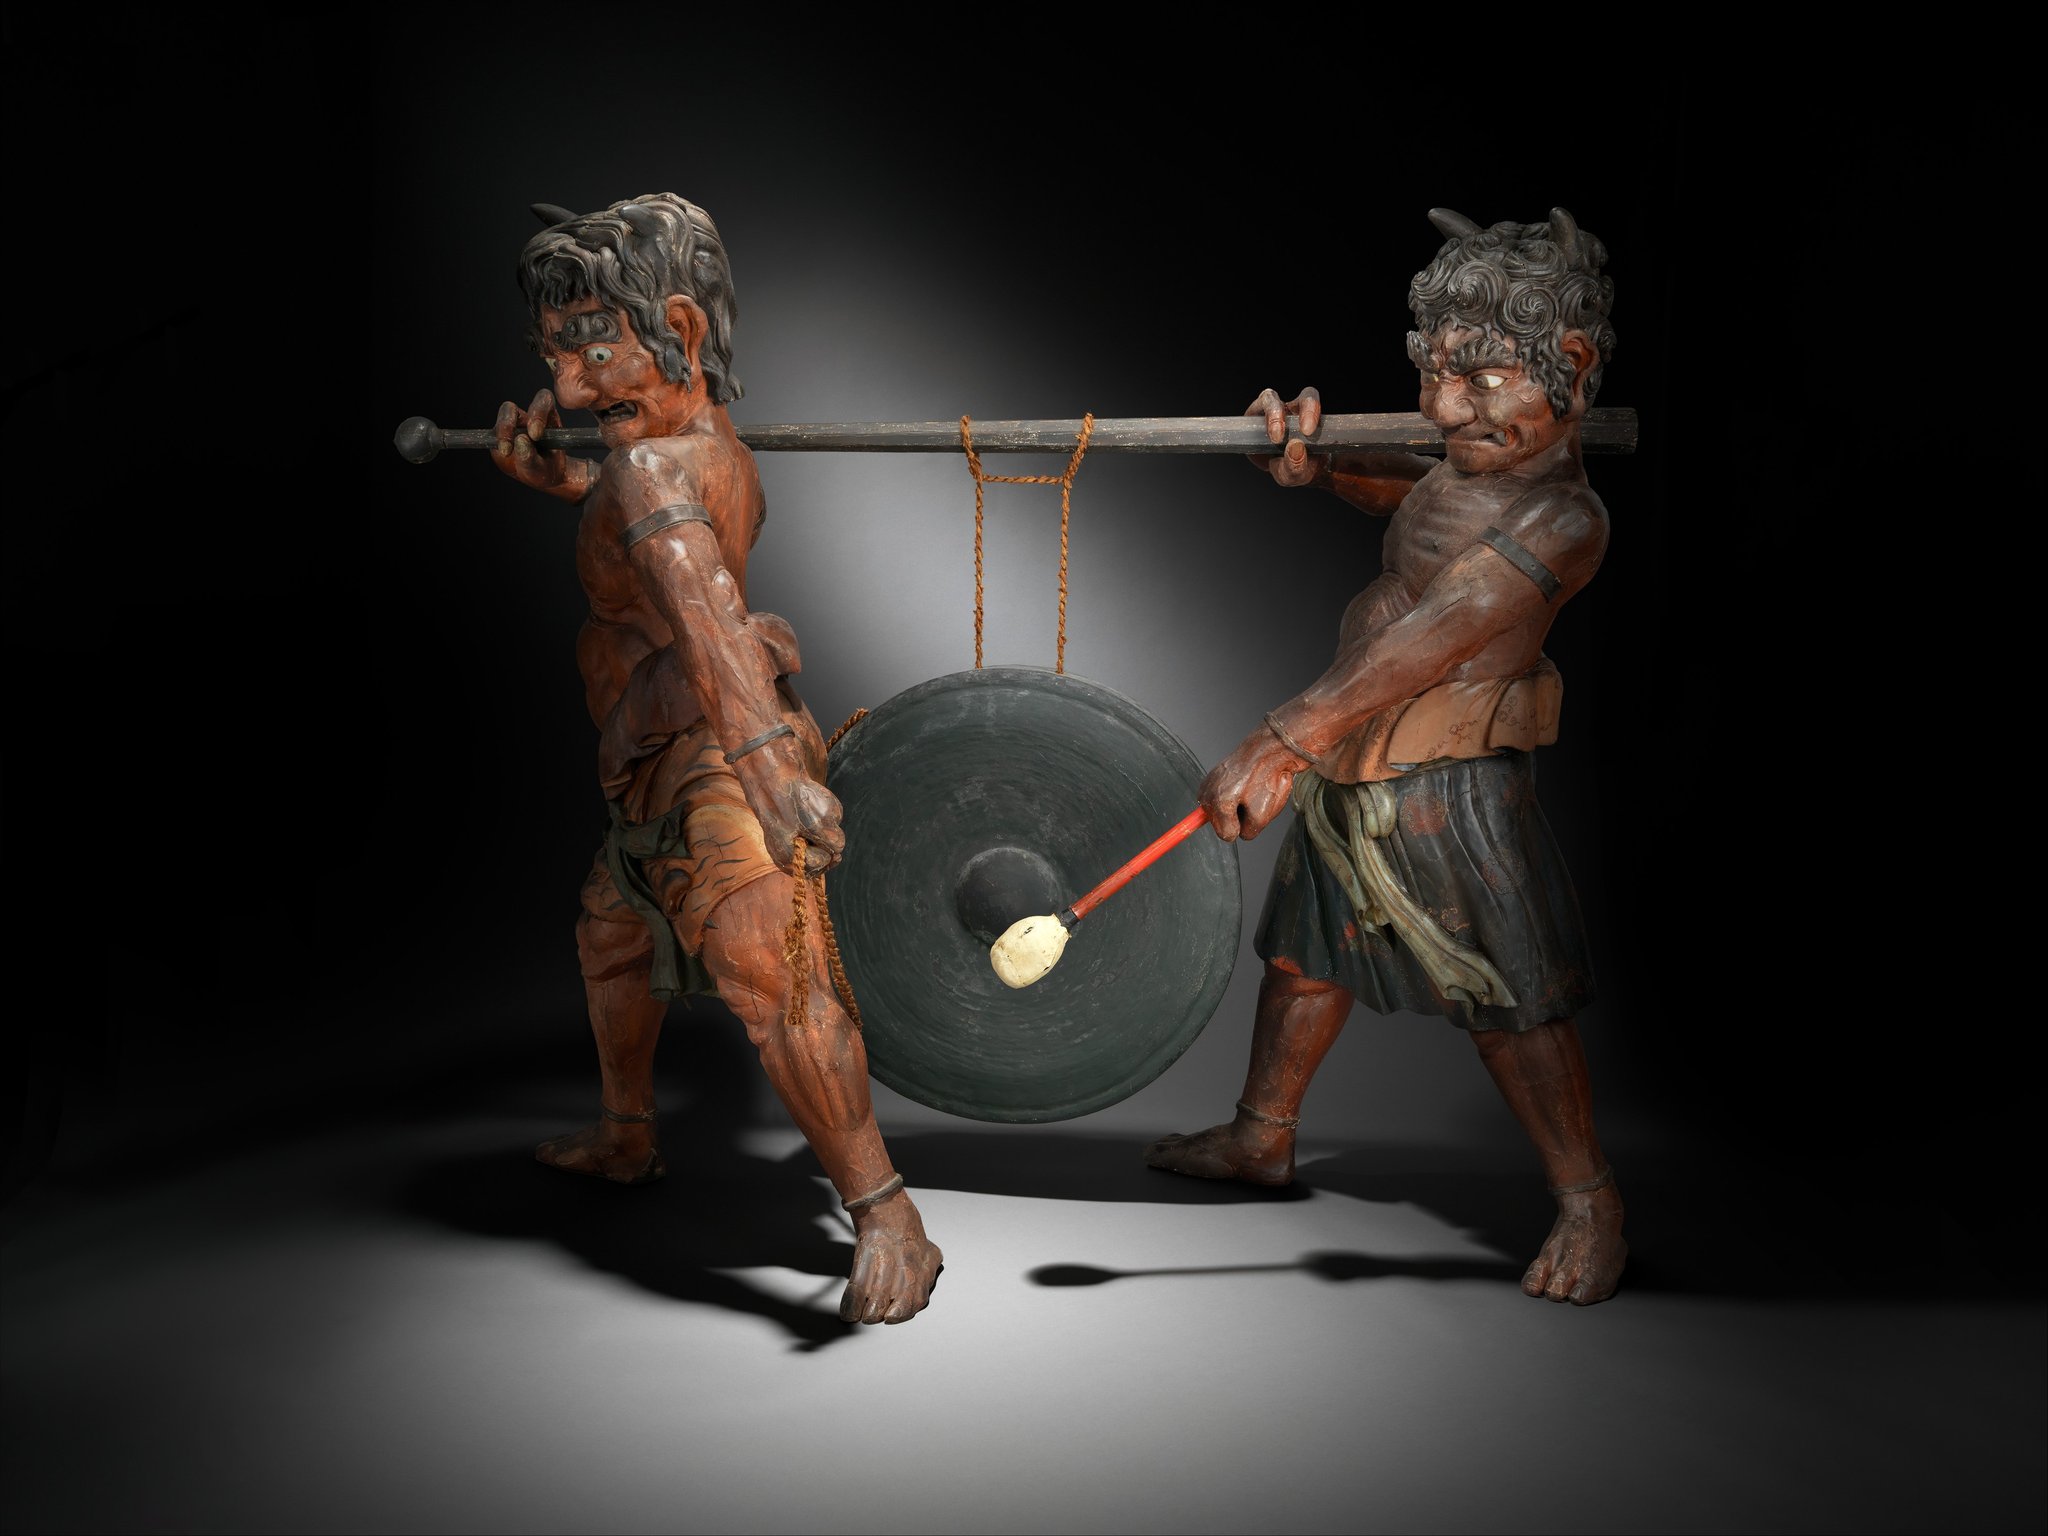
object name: gong held by oni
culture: japanese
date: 1867-1900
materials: lacquer, metal, wood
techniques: polychrome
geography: japan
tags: demons